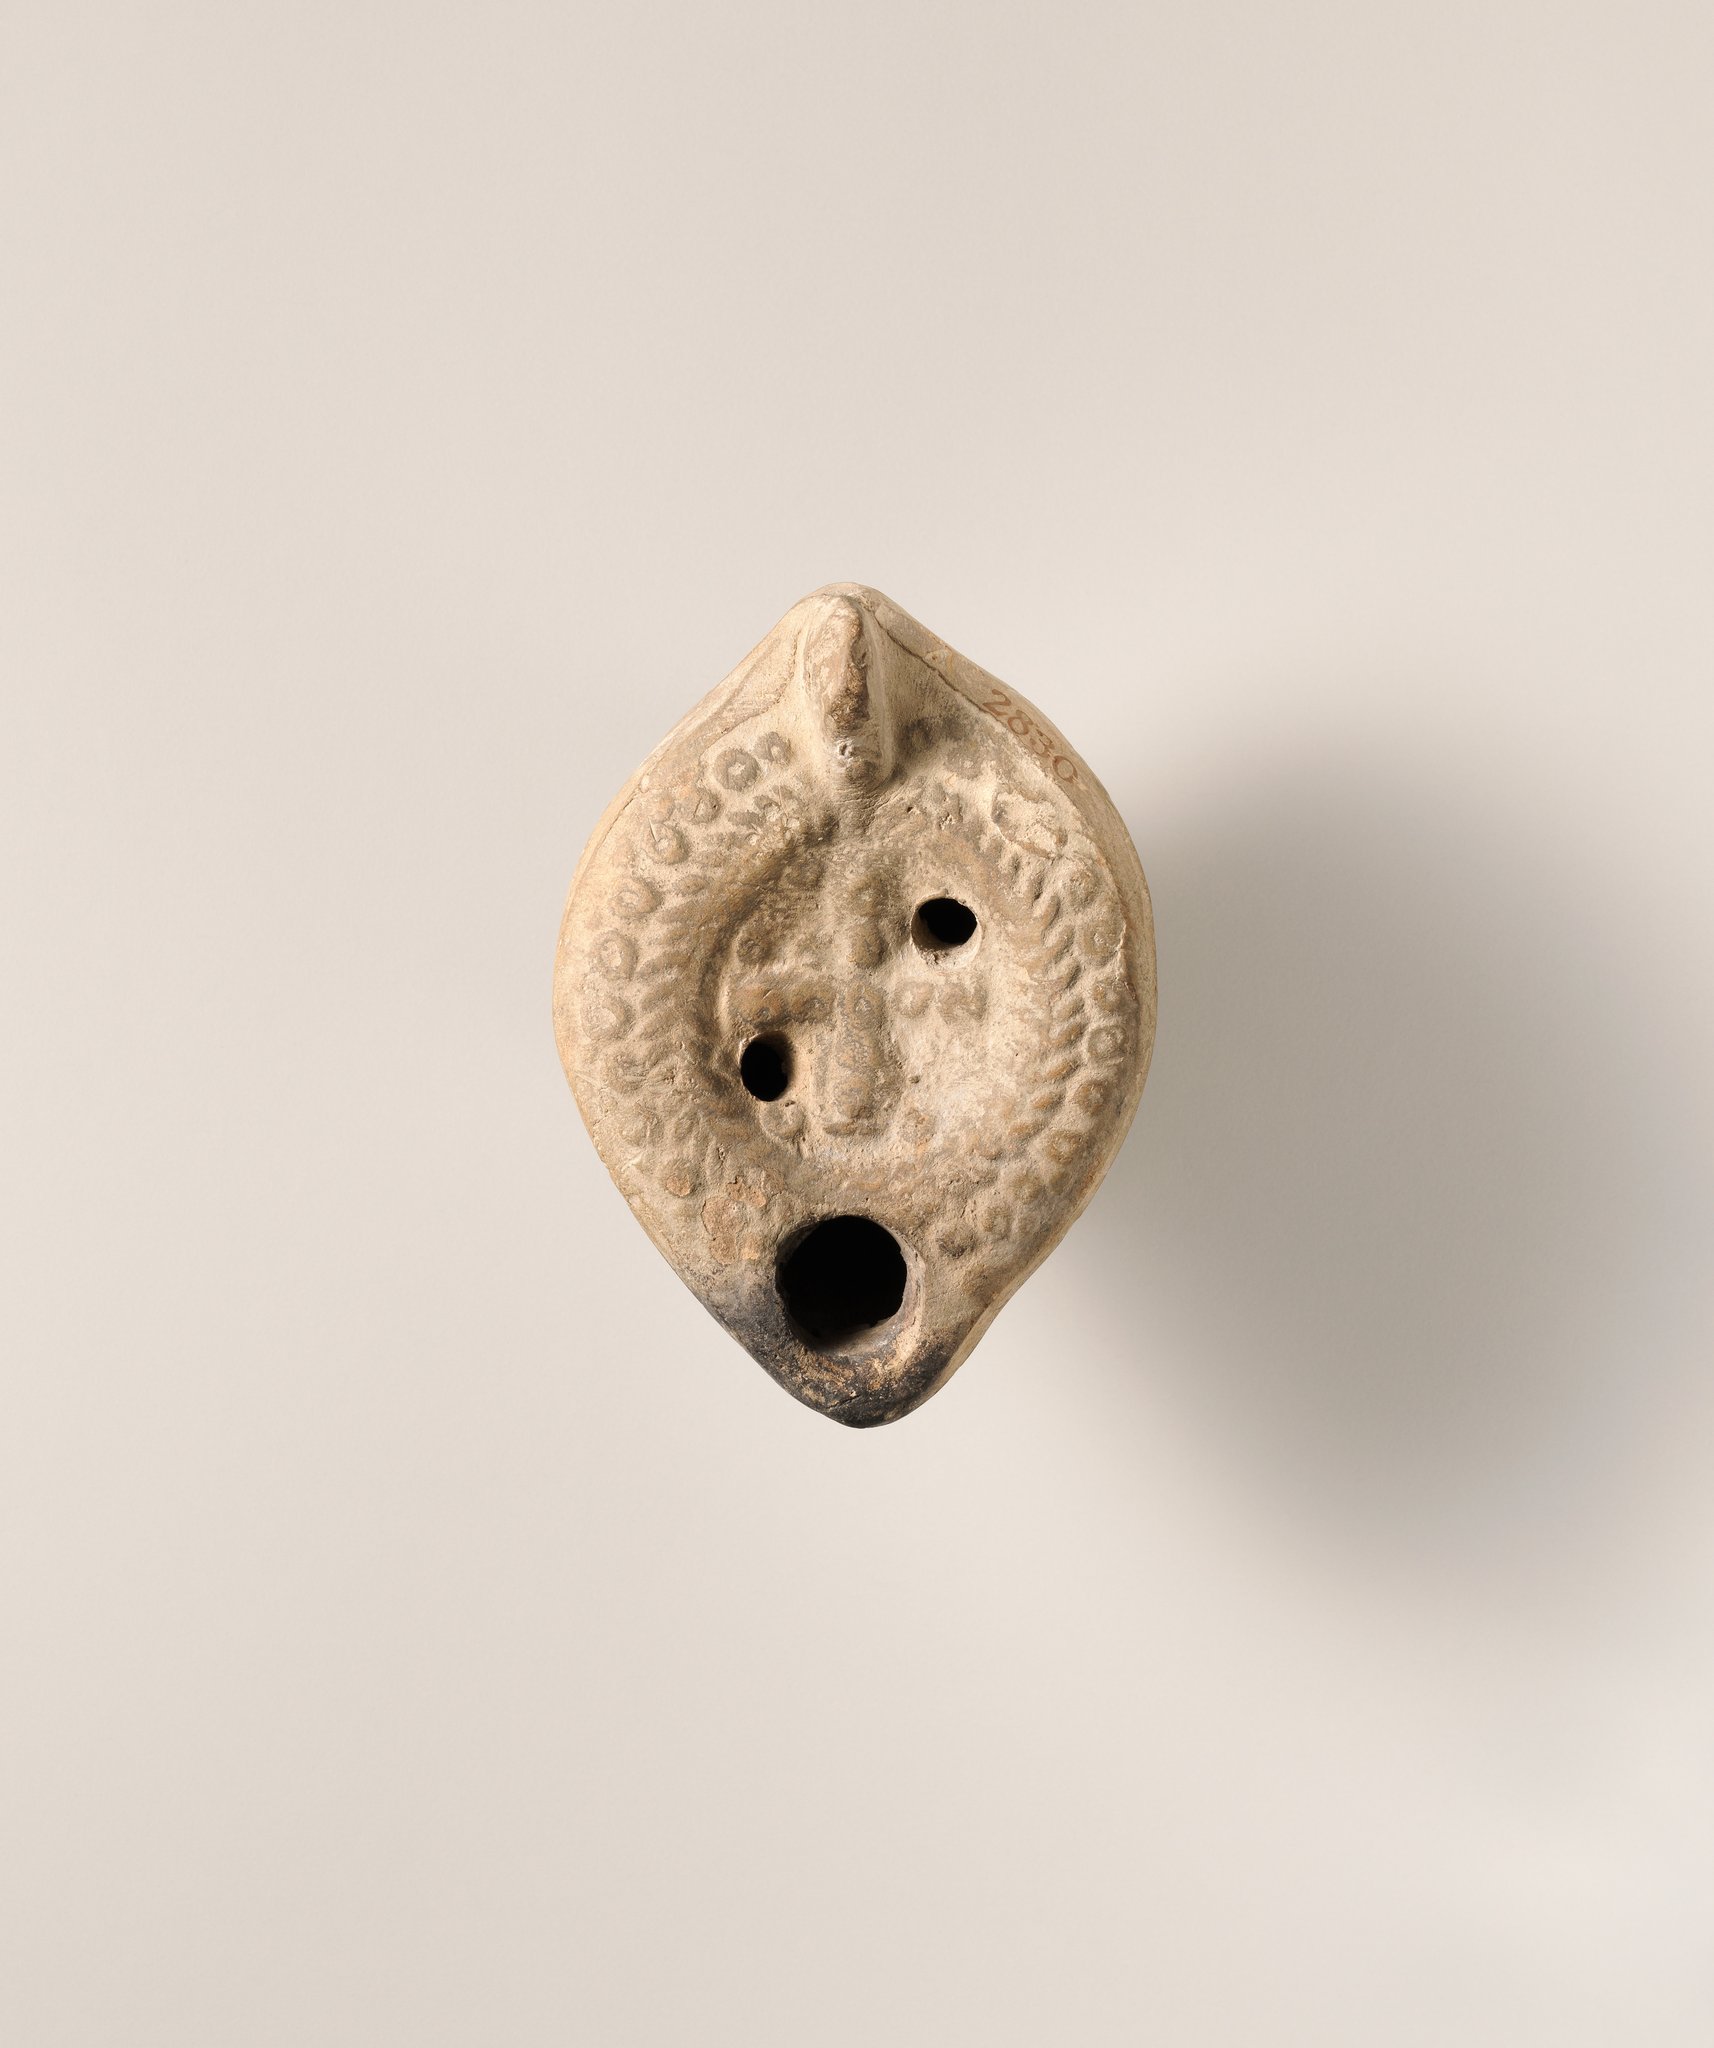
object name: lamp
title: Terracotta oil lamp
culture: roman, cypriot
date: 401-500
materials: terracotta